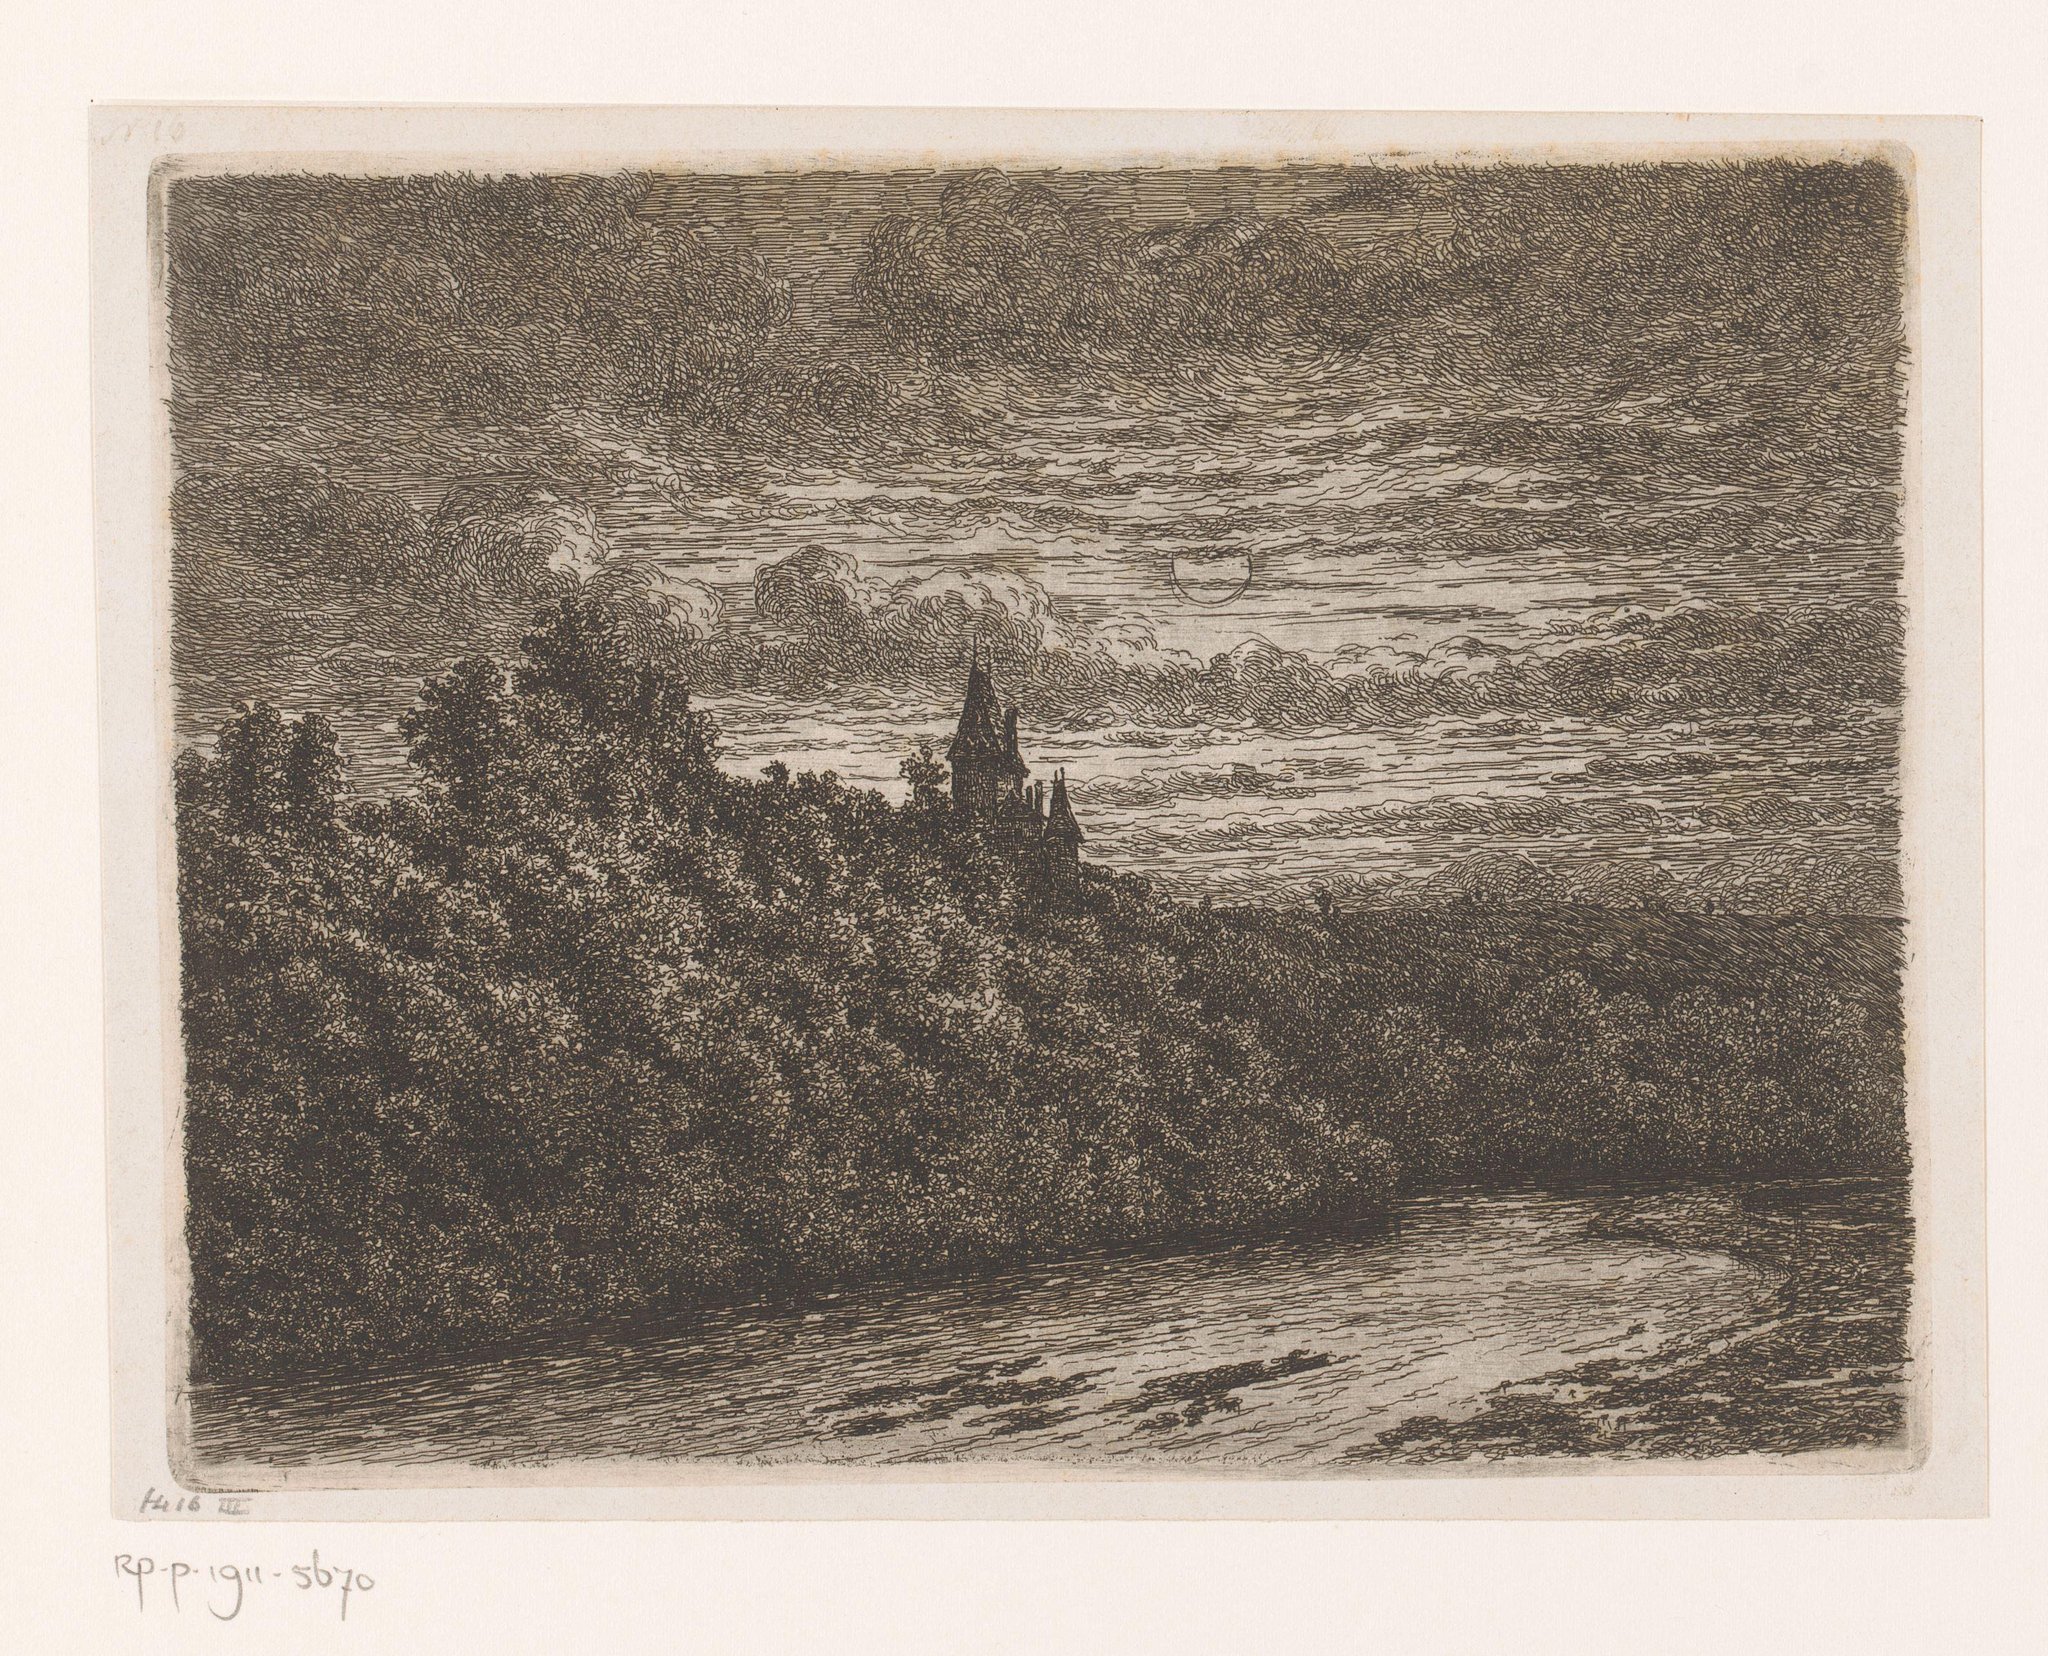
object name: print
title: Gezicht op een kasteel op de hoge linkeroever aan een rivier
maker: jean pierre françois lamorinière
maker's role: print maker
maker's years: 1828-1911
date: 1838-1911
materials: paper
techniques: etching, intaglio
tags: castle, river, landscape with tower or castle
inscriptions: collector's mark: Lugt 1485, collector's mark: Lugt 2228